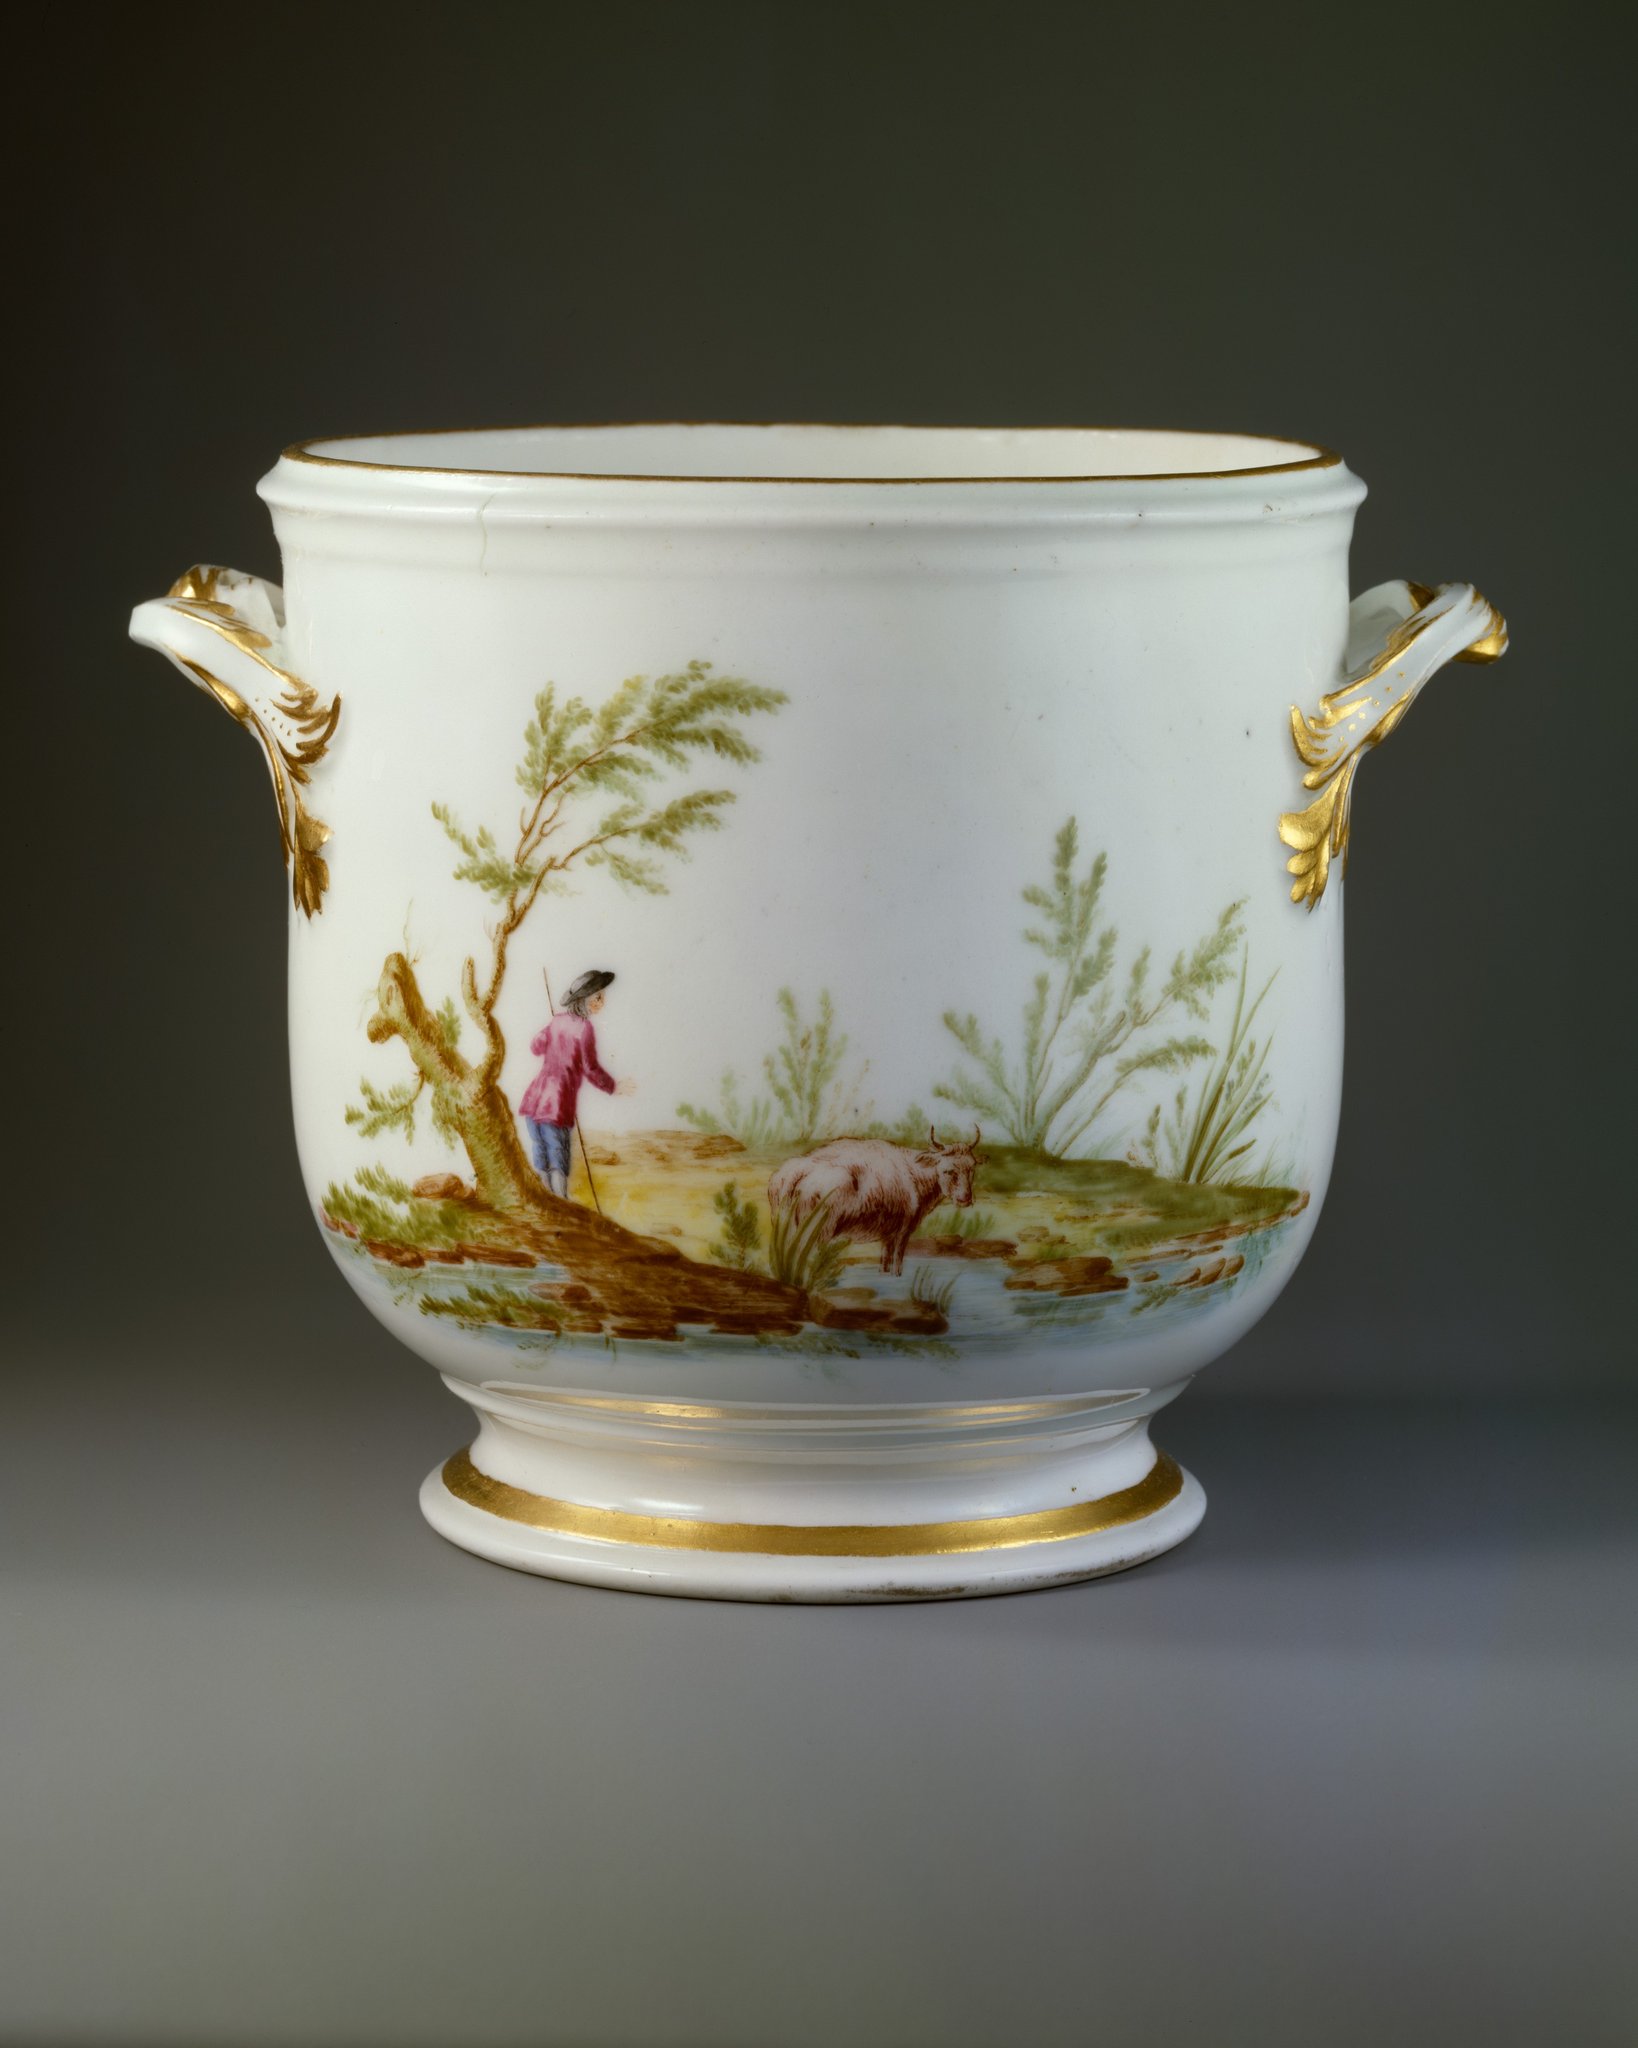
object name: wine cooler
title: Wine cooler (seau à demi-bouteille) (one of a pair)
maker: vincennes manufactory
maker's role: manufactory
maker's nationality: french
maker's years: 1740-1756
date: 1751-1752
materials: soft paste porcelain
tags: men,cows,landscapes,trees